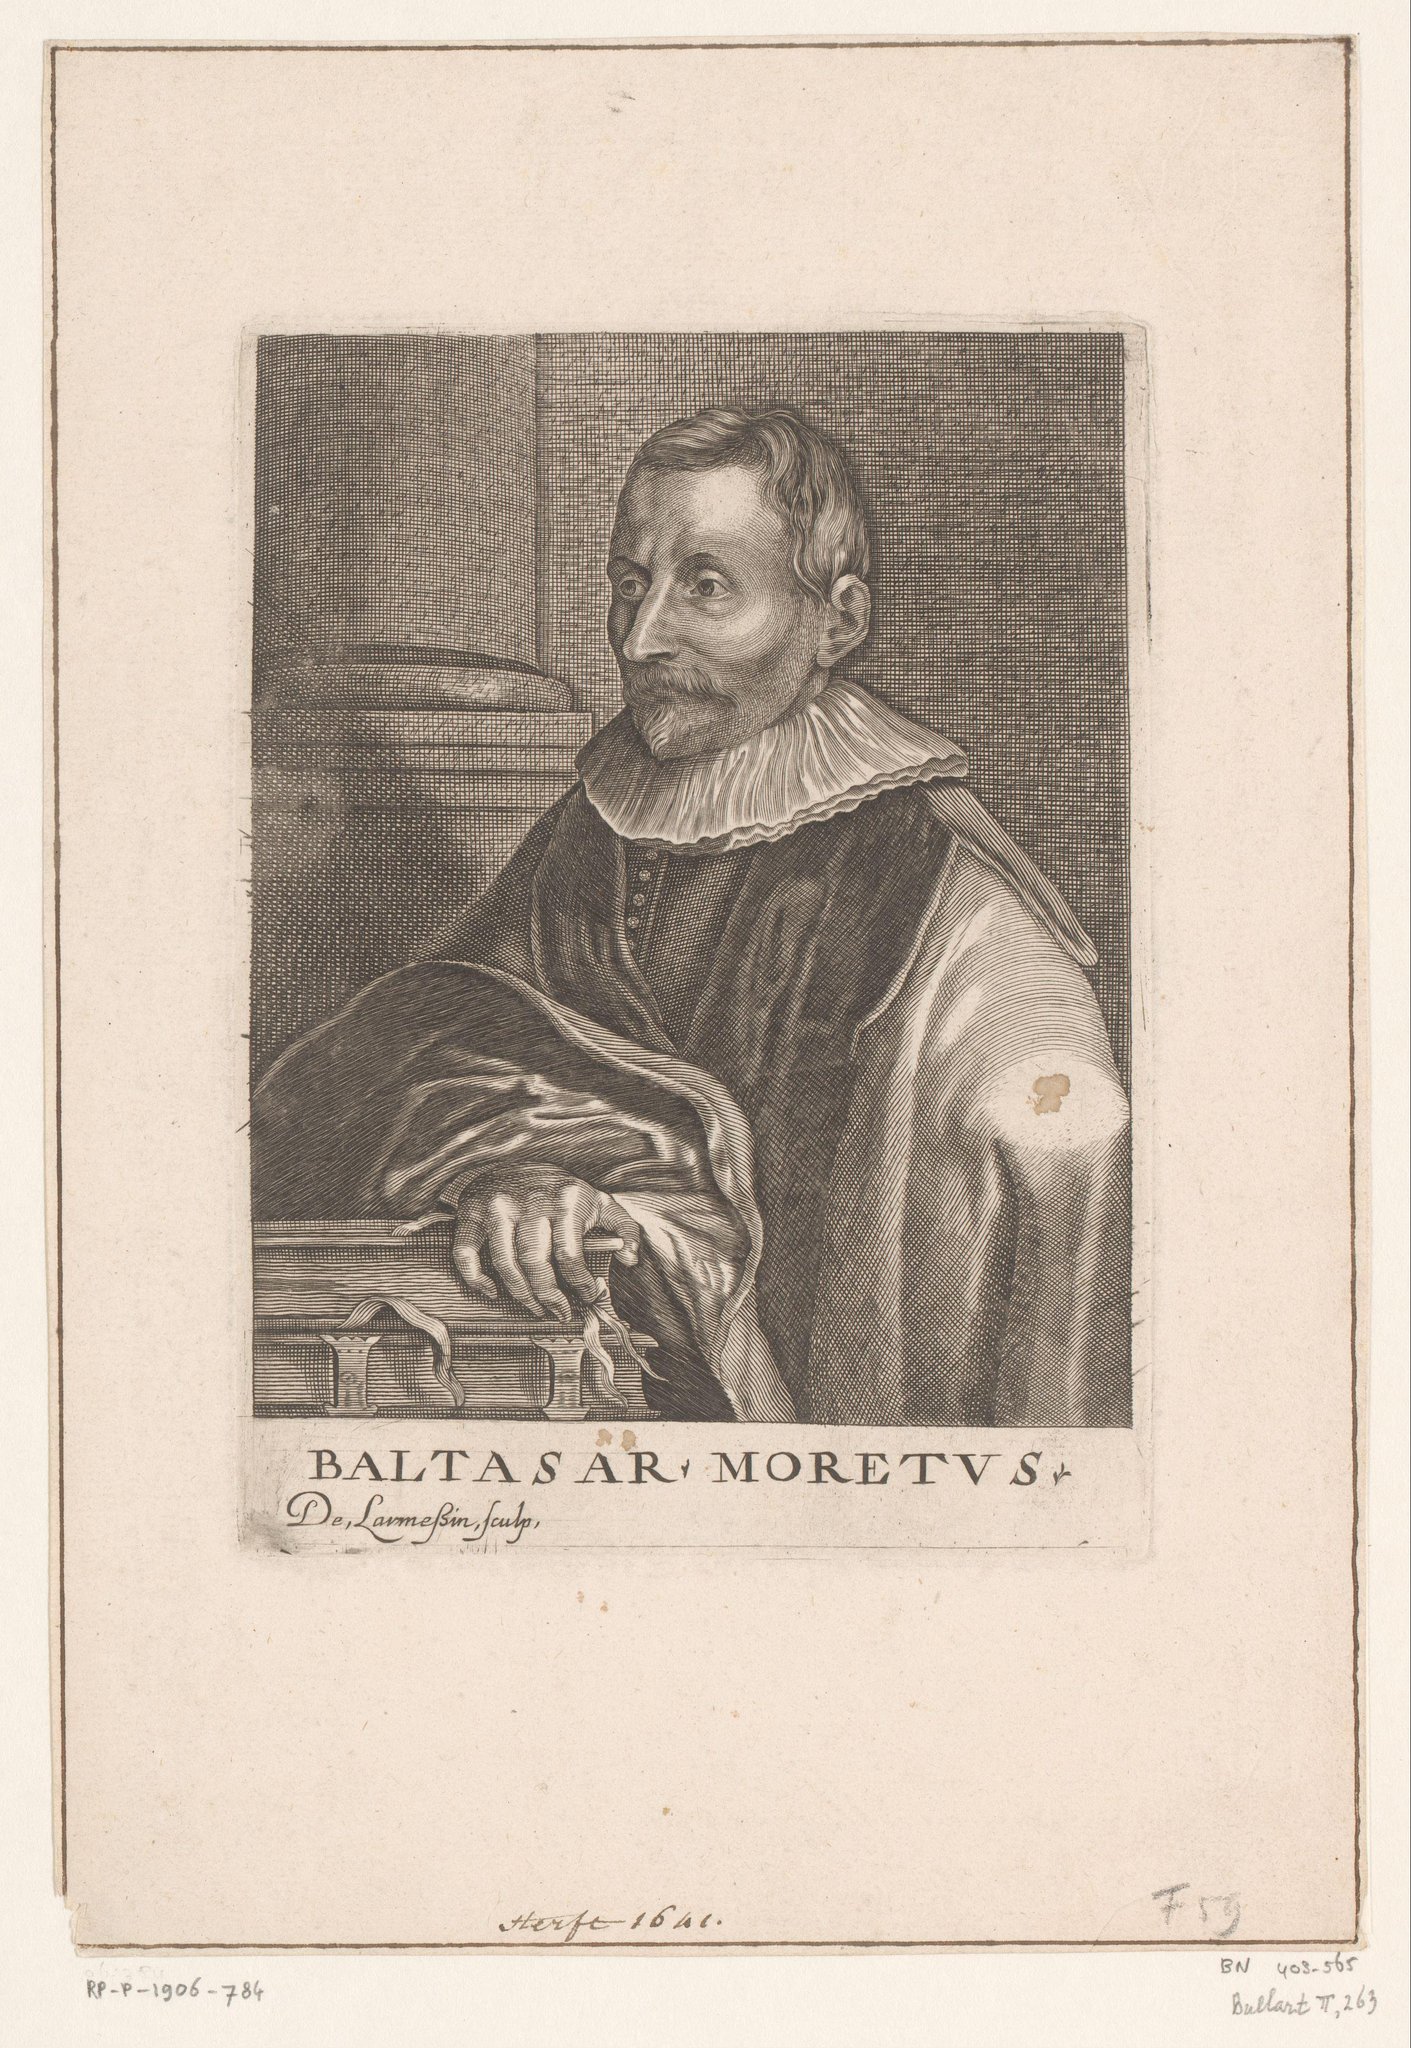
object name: print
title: Portret van Balthasar (I) Moretus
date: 1682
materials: ink, paper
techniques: engraving, pen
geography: brussels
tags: antwerp, printer, publisher, balthasar moretus (i), historical persons, persons ~ printing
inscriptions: number: ‘1829’, collector's mark: Lugt 2228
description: Prent gebruikt voor: Bullart, Isaac. Académie des Sciences et Arts contenant les vies et éloges his. des hommes illustres qui ont excellé en ces professions depuis environ quatre siècles. Brussel: François Foppens, 1682. Het boek werd in 1682 eveneens in Amsterdam uitgegeven door de erfgenamen van Daniel Elzevier. Ieder portret betreft een illustratie bij de biografie van een kunstenaar of geleerde. De meeste portretten werden door Nicolas de Larmessin vervaardigd (162), 93 door De Boulonois en een derde door ongeïdentificeerde prentmakers. Dit betreft een illustratie op p. 263, deel II.